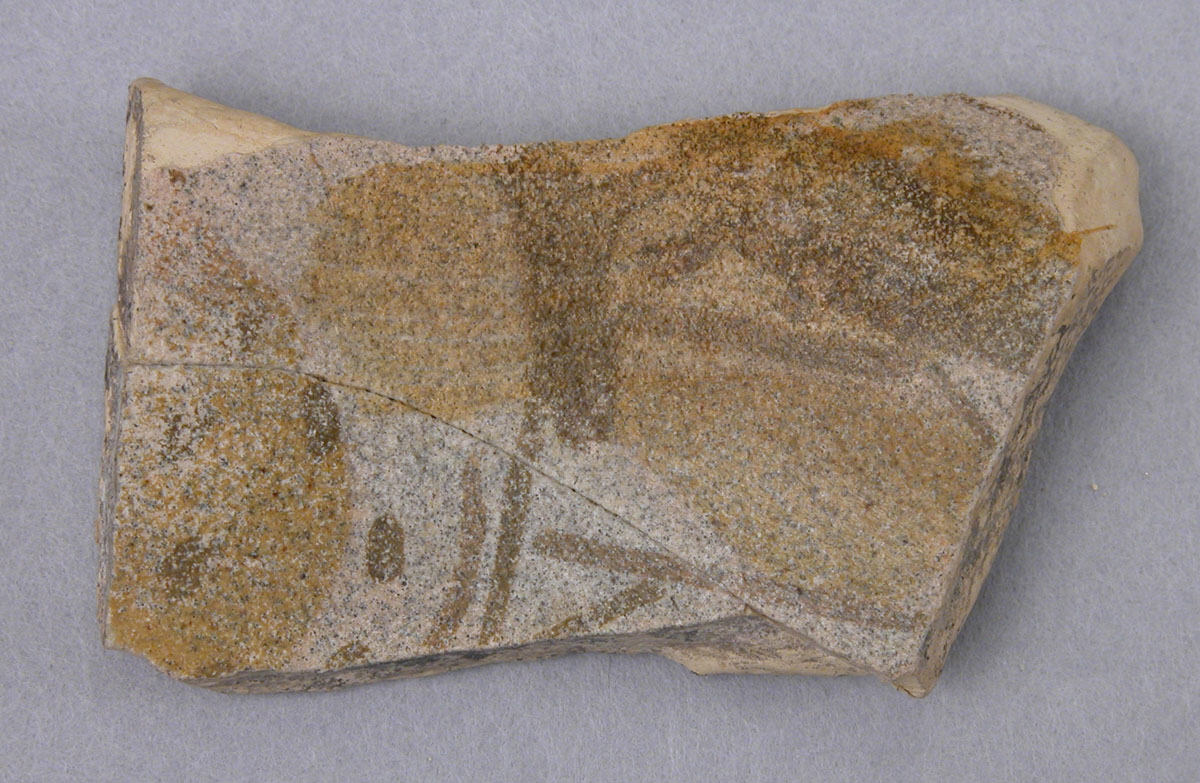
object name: fragment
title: Ceramic Fragment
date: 801-900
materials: earthenware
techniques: glazing, painting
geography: saudi arabia